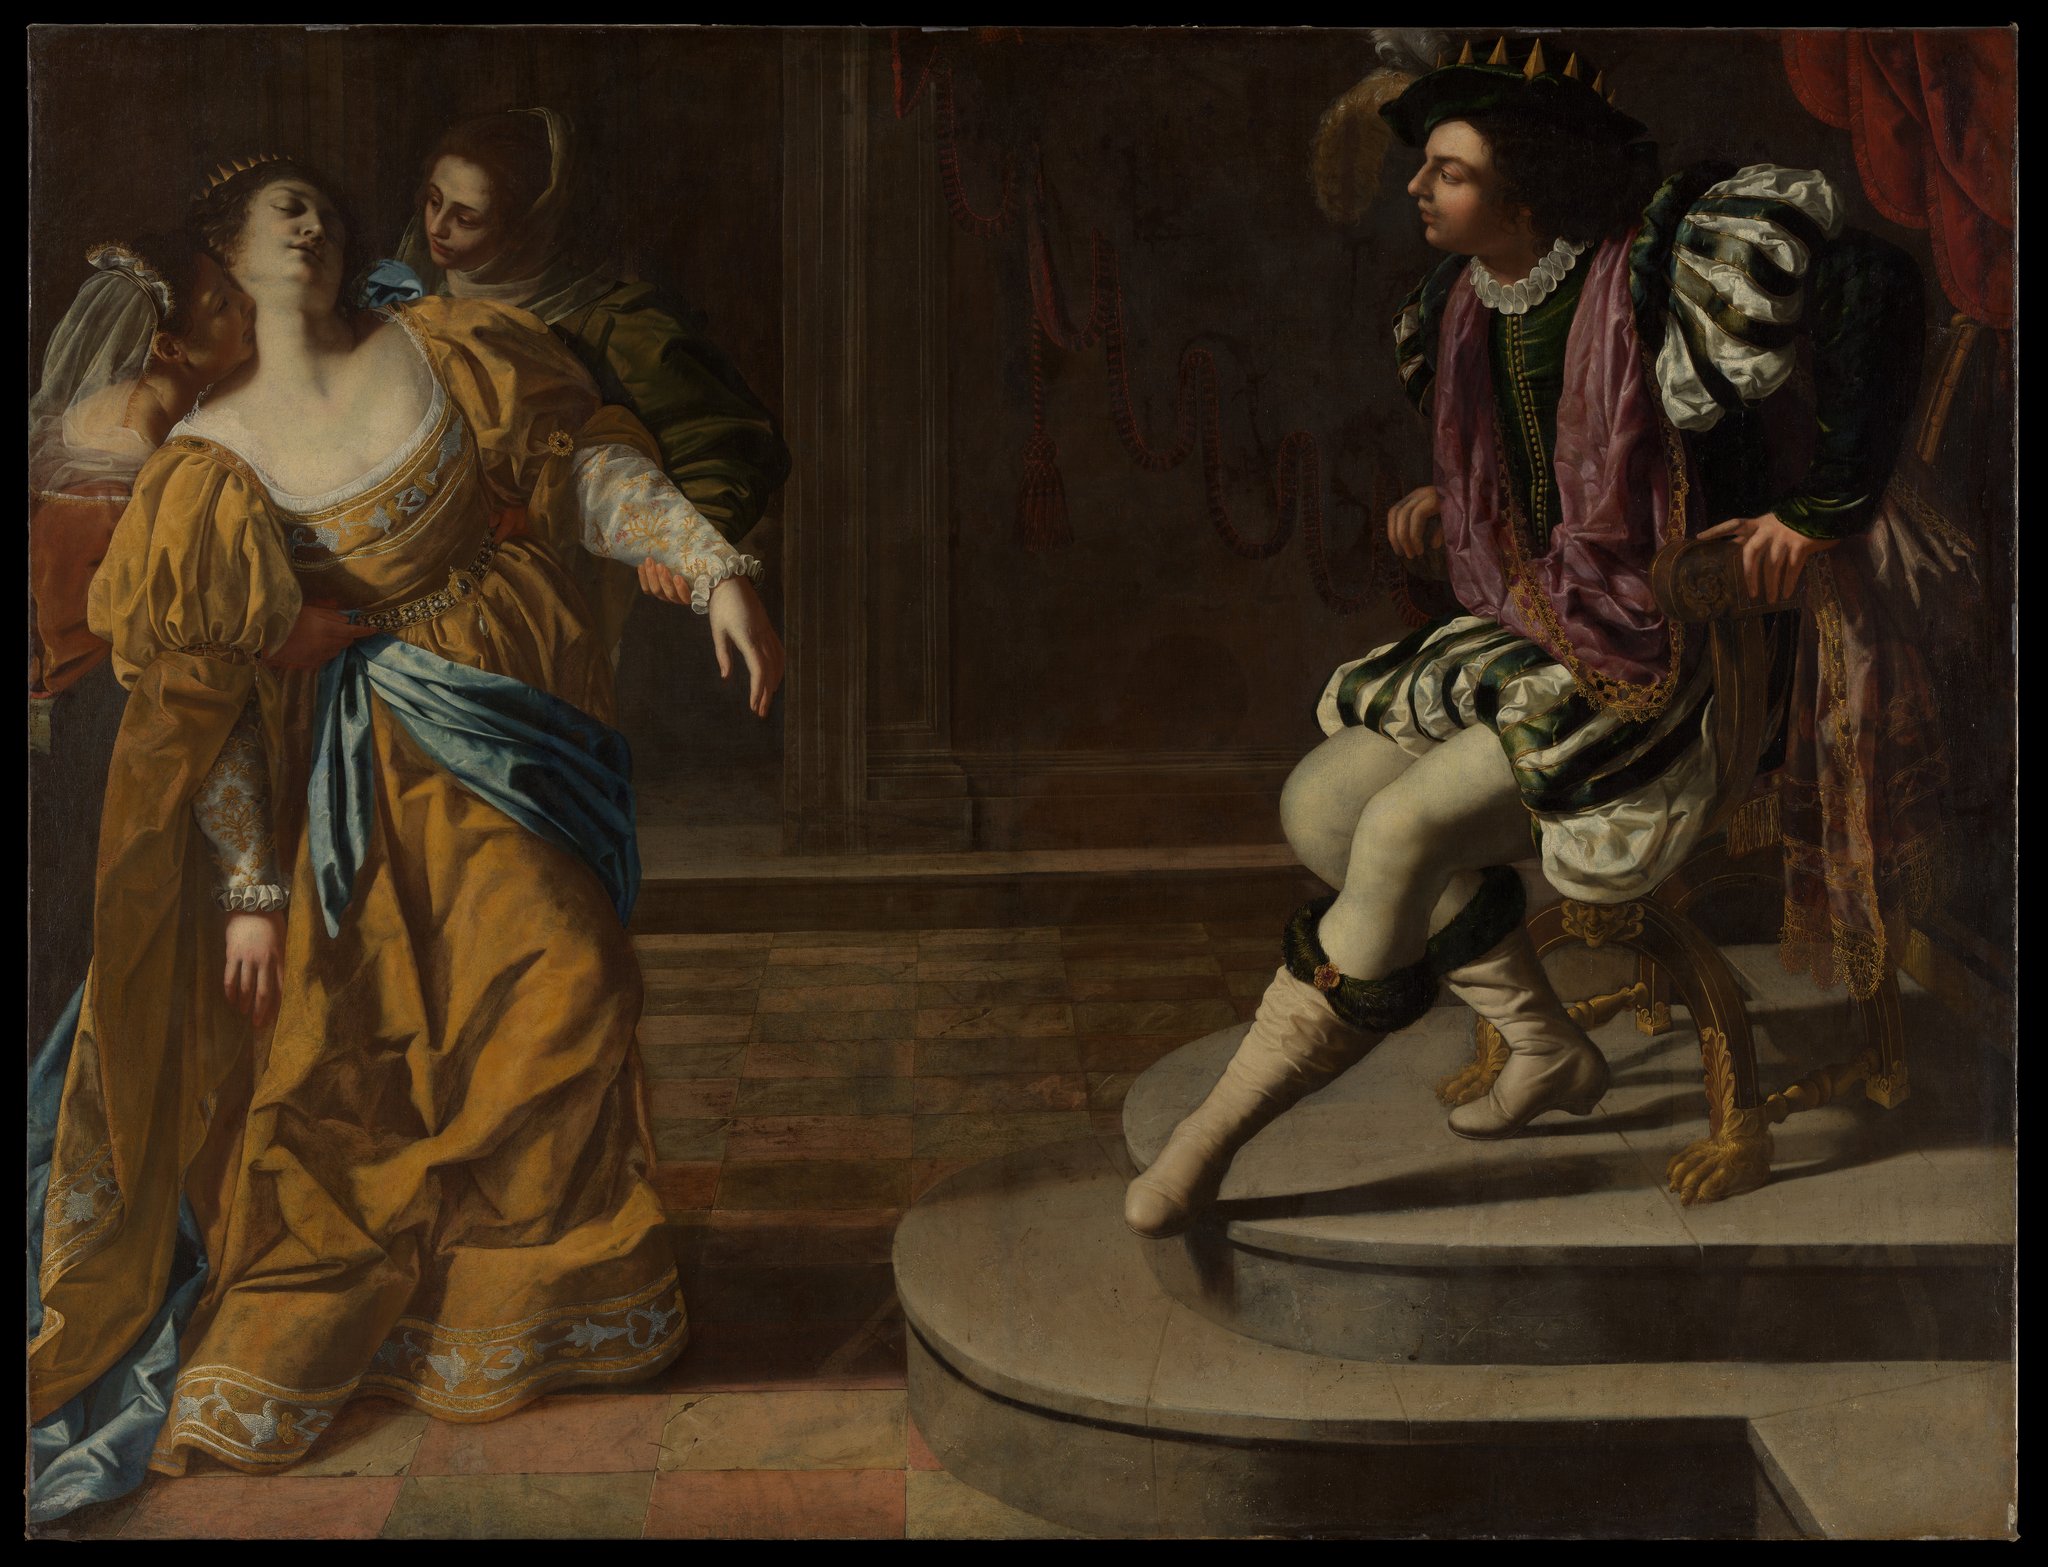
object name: painting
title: Esther before Ahasuerus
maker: artemisia gentileschi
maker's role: artist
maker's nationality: italian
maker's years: 1593-1654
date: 1620-1629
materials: canvas, oil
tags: men,women,esther,ahasuerus